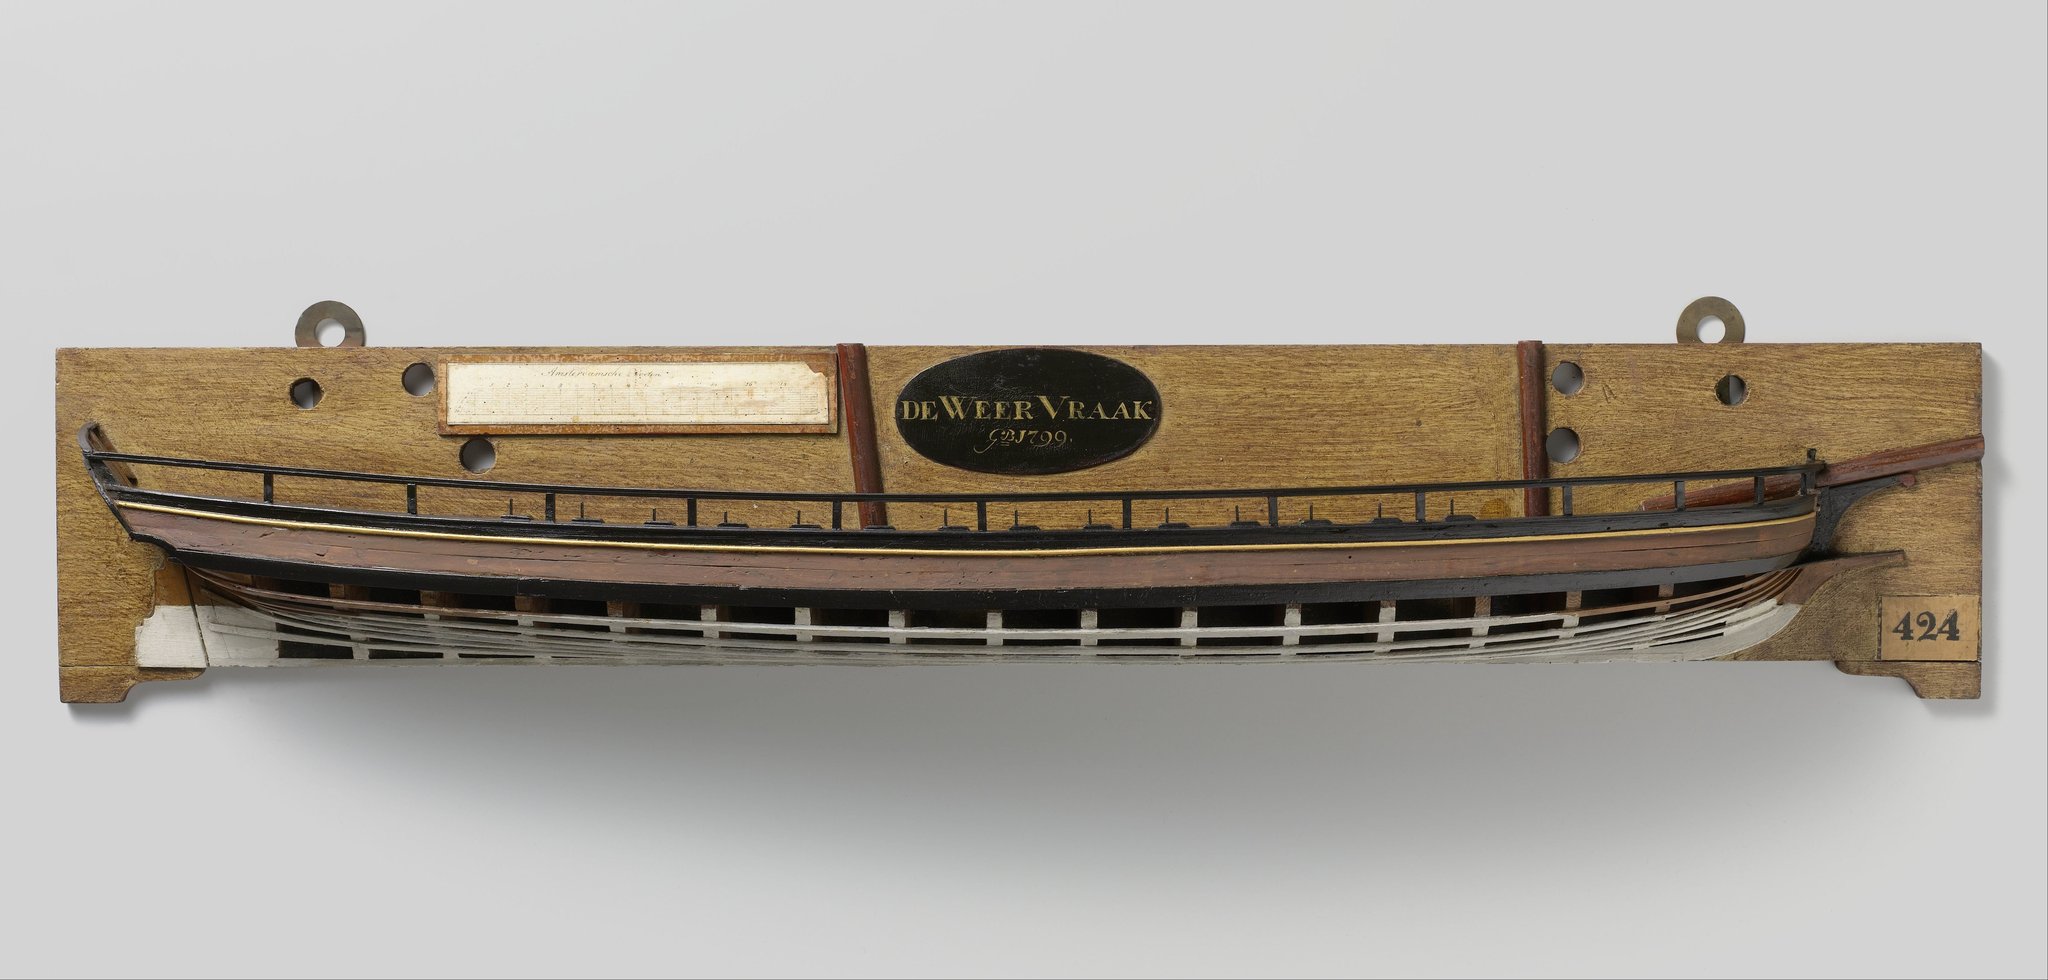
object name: half model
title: Half Model of a 3-Gun War Galley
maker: Anonymous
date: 1799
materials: brass, wood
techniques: polychromy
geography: netherlands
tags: valk (schip), weerwraak (schip)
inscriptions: label, bottom right: ‘424’ former inventory label, inscription, top centre, on an oval black label: ‘DE WEER VRAAK / GB 1799.’, scale, top centre: paper scale in Amsterdam feet